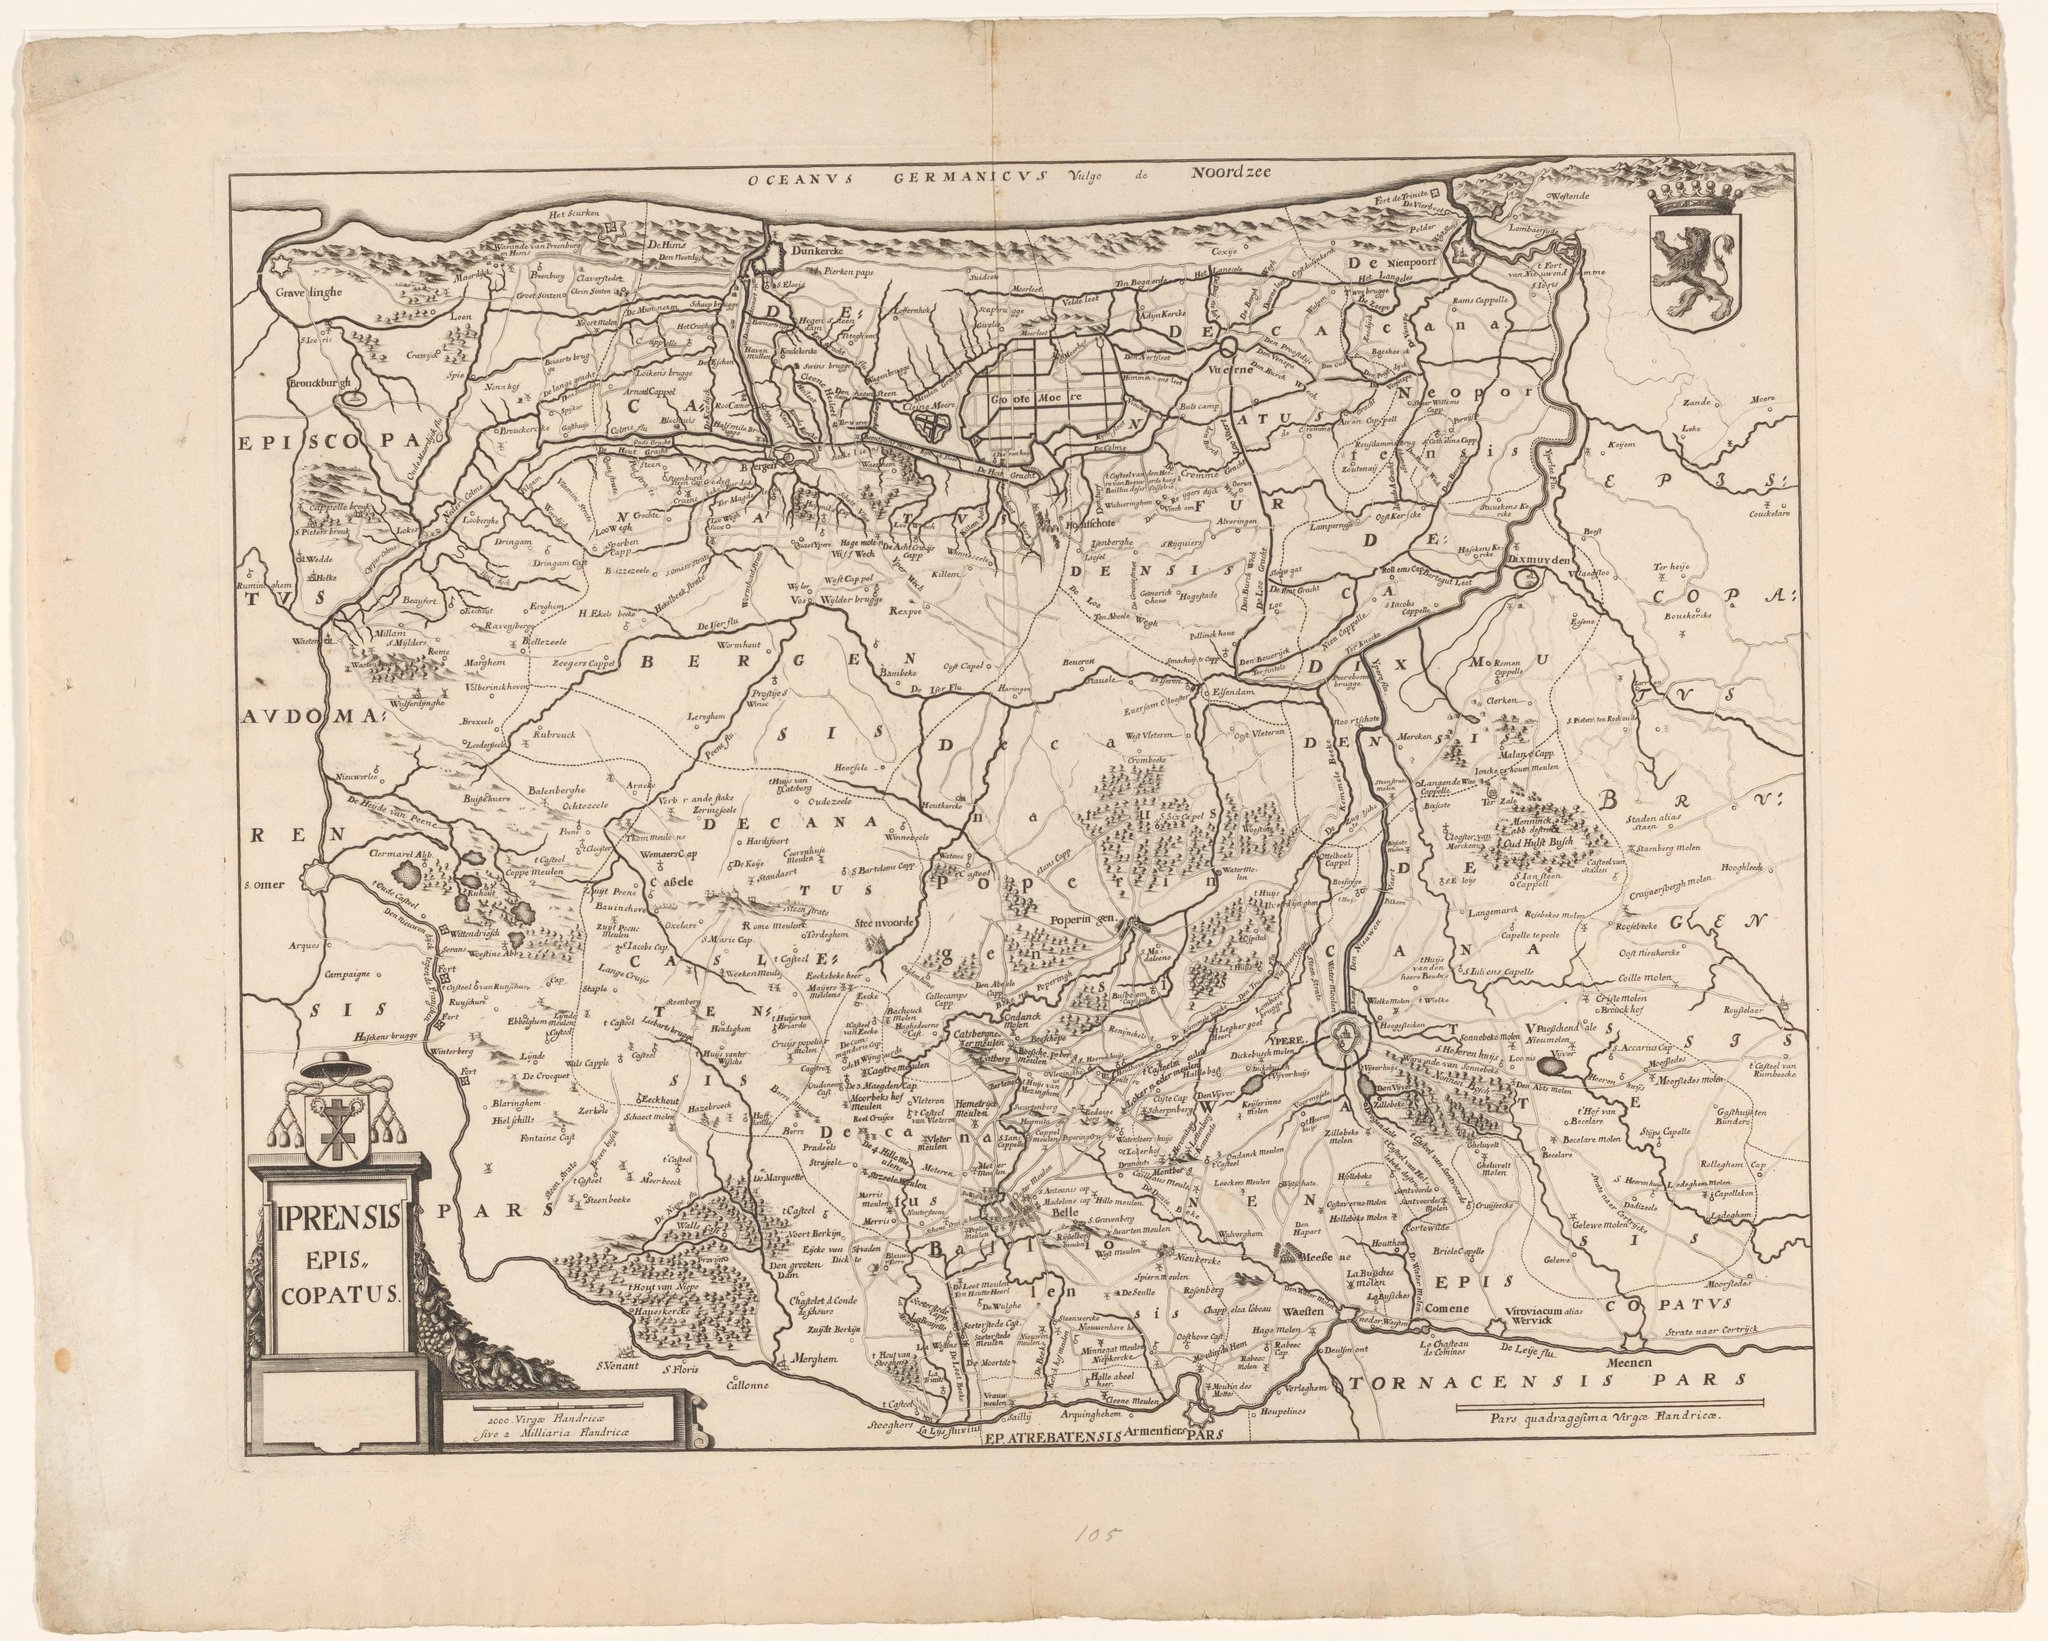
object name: map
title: Iprensis episcopatus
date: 1735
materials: paper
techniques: engraving, etching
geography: brussels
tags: coat of arms (as symbol of the state, etc.) (+ city; municipal), maps of separate countries or regions, coat of arms (as symbol of the state, etc.) (+ province; provincial)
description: Kaart van het bisdom Ieper. Linksonder de titelcartouche met bovenin het wapen van het bisdom Ieper. Rechts daarvan een cartouche met schaalstok: 2000 Virgae Flandricae / Sive 2 Milliaria Flandrica. Rechtsonder een schaalstok: Pars quadragesima Virgae Flandricae. Rechtsboven het wapen van Vlaanderen.